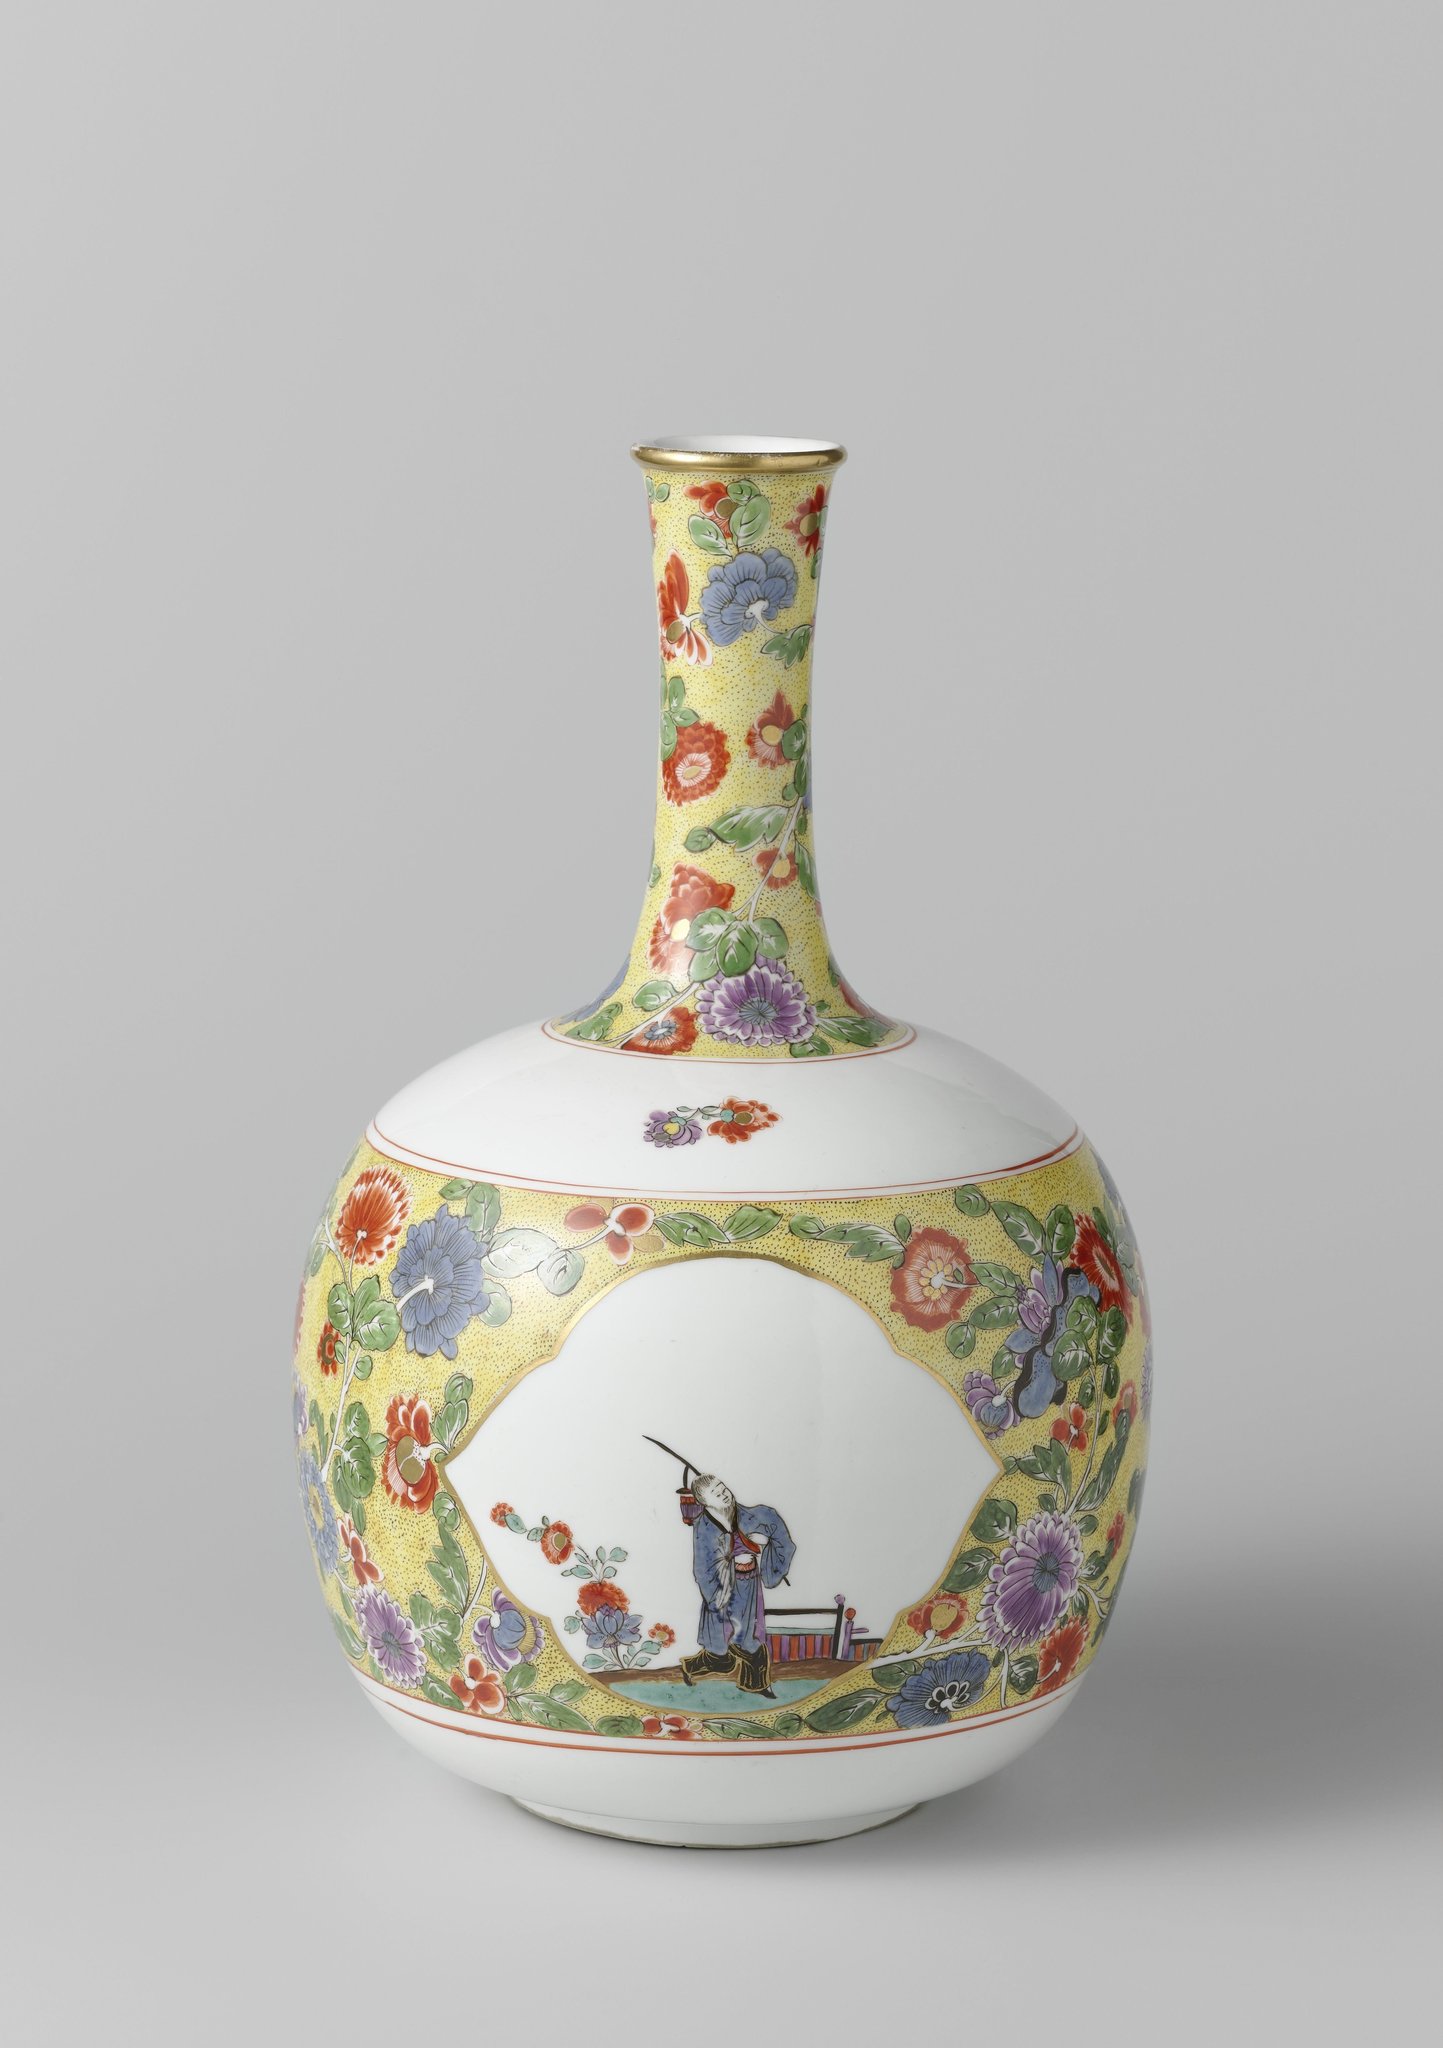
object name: decoratief object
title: Vase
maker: johann daniel rehschuh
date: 1730-1735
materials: porcelain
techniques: painted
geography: meissen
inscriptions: mold mark: ‘X (Rückert 1996, afb. 6, nr. 33)’, factory mark: ‘AR’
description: Meissener Porzellan Manufaktur Meissen, c. 1730–1735 hard-paste porcelain